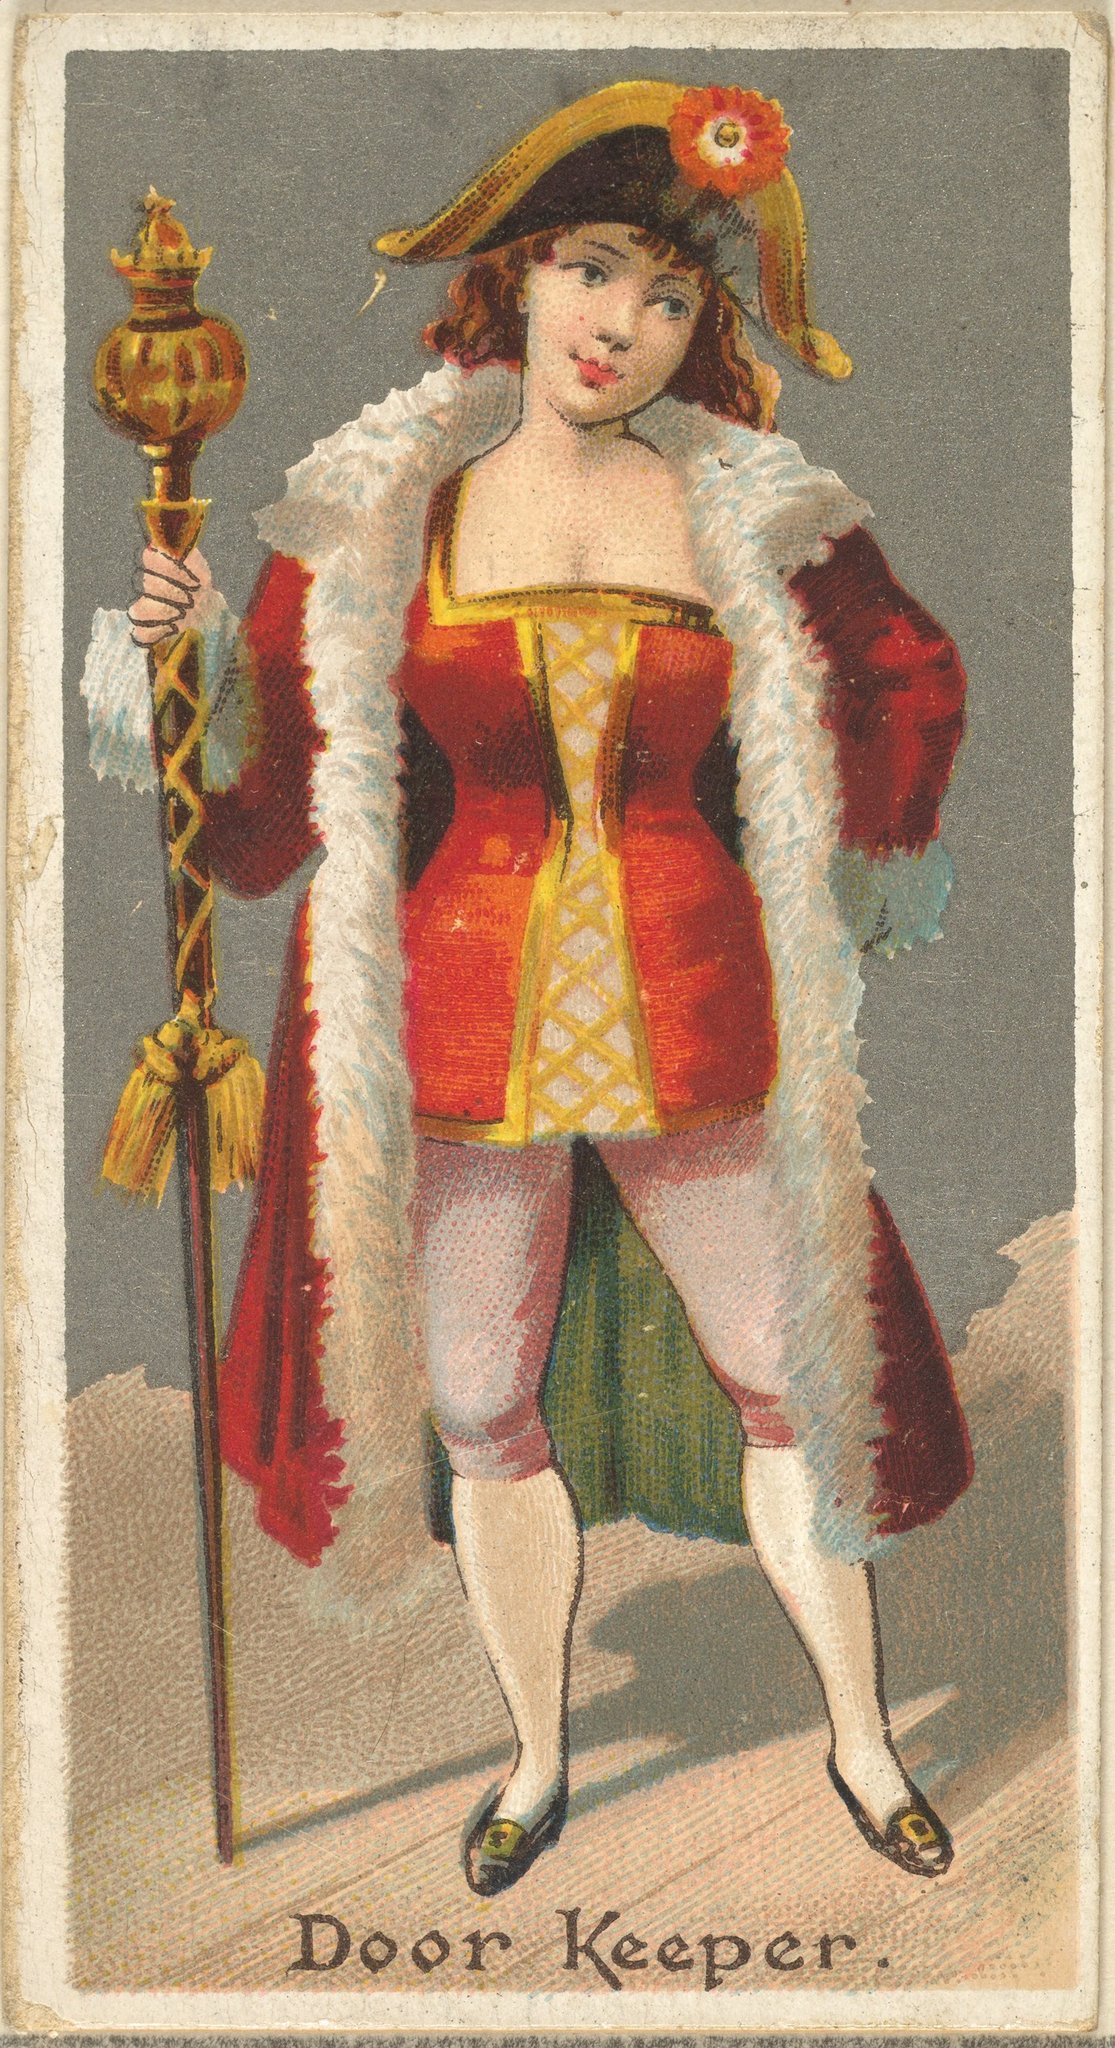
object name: print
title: Door Keeper, from the Occupations for Women series (N166) for Old Judge and Dogs Head Cigarettes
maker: goodwin & company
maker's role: publisher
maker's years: 1850-1950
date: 1887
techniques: color lithograph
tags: women